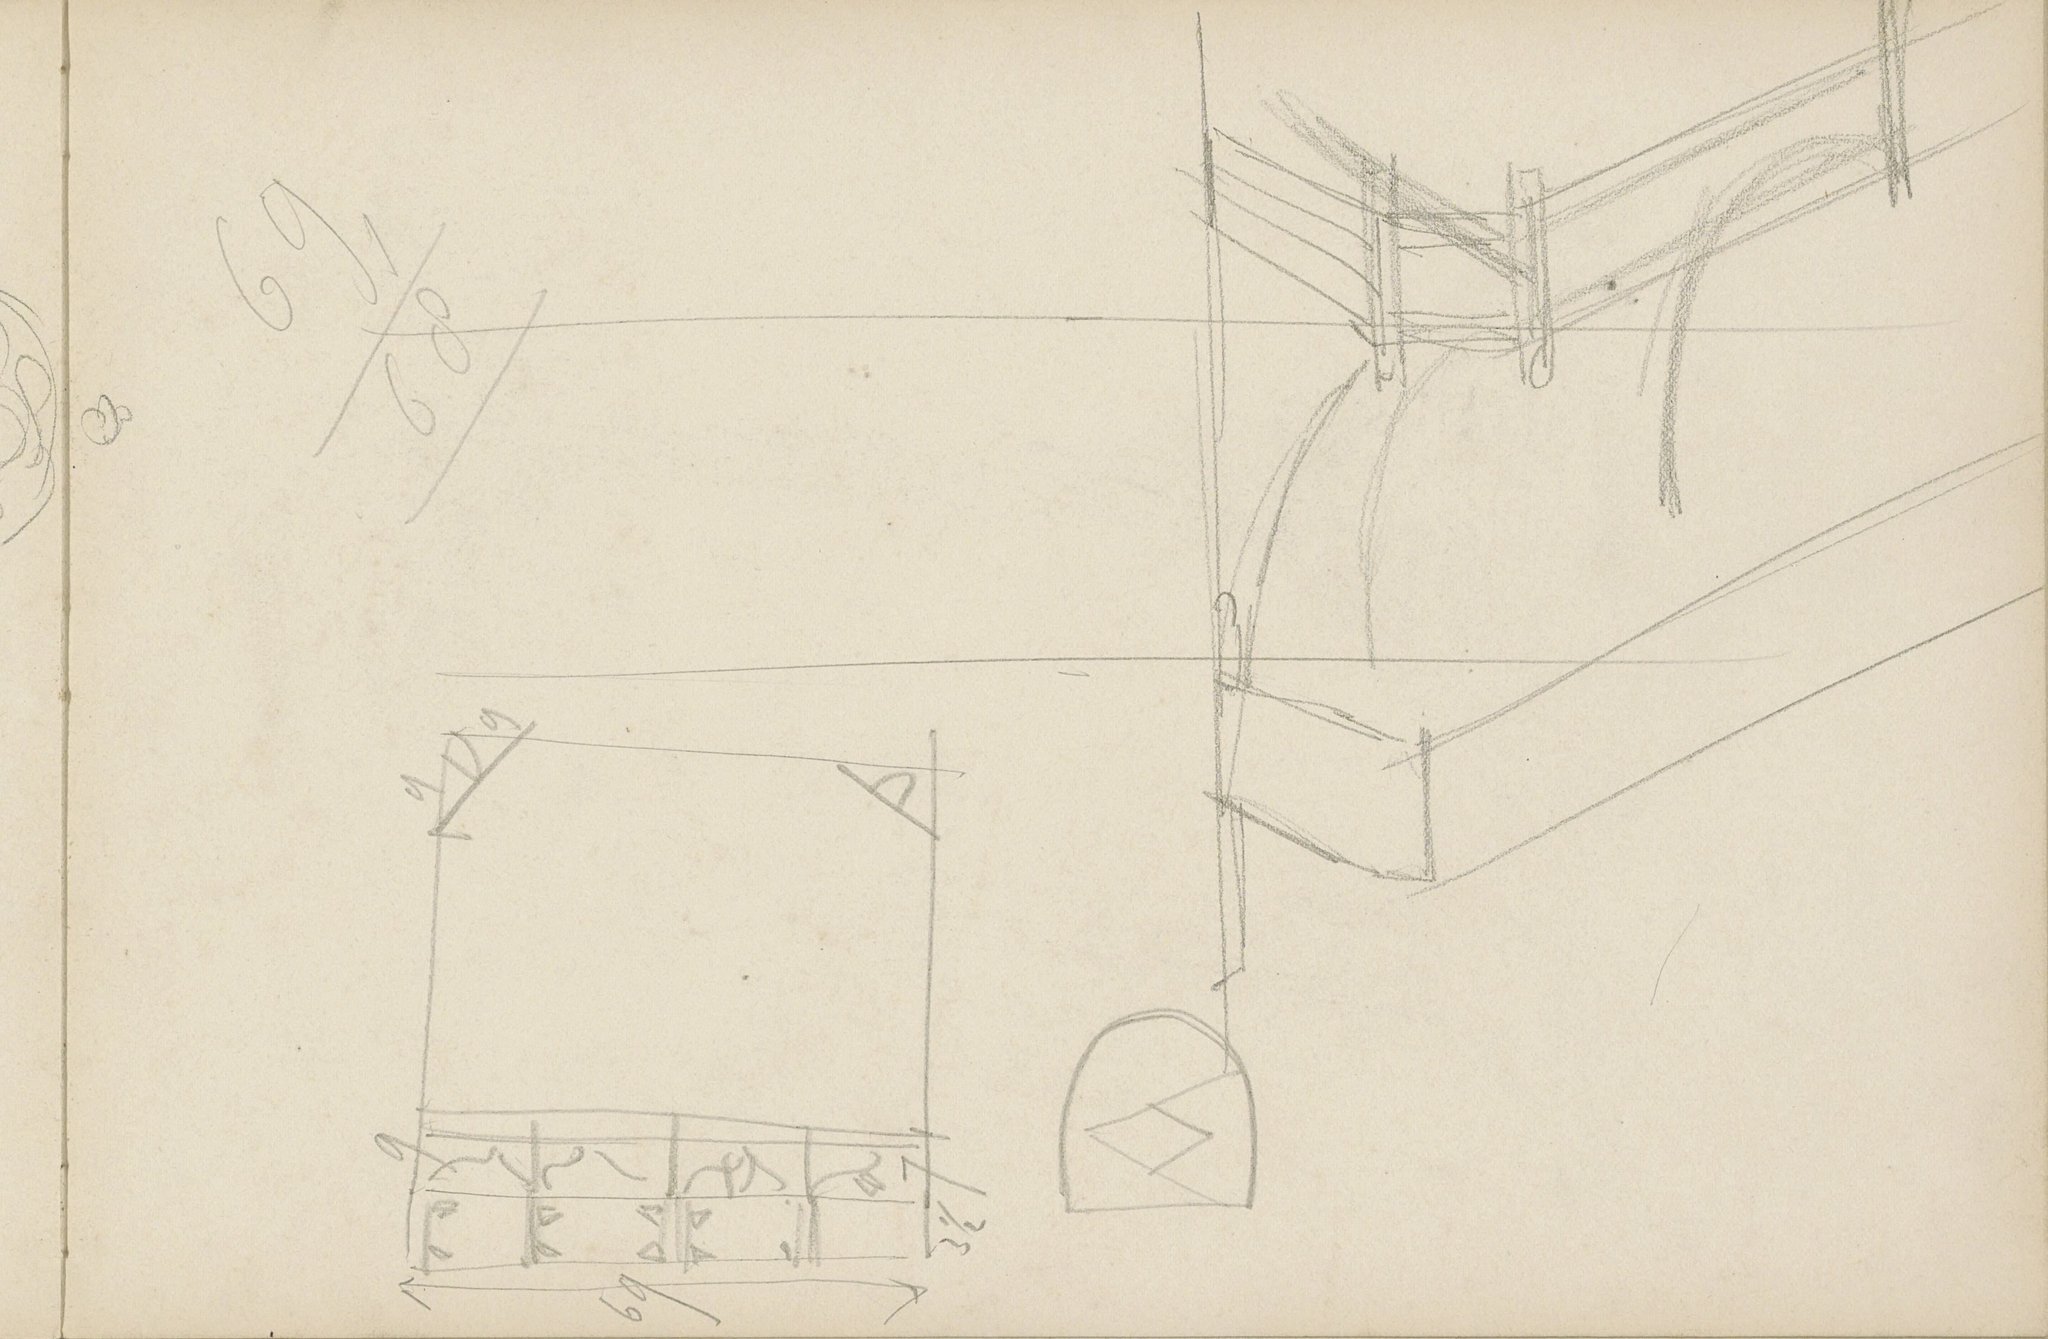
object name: sketchbook leaf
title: Studies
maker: carel adolph lion cachet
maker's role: draughtsman, print maker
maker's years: 1864-1945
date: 1908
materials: paper, pencil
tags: architecture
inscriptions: annotation: ‘[...]’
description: Blad 7 recto uit een schetsboek met 25 bladen.